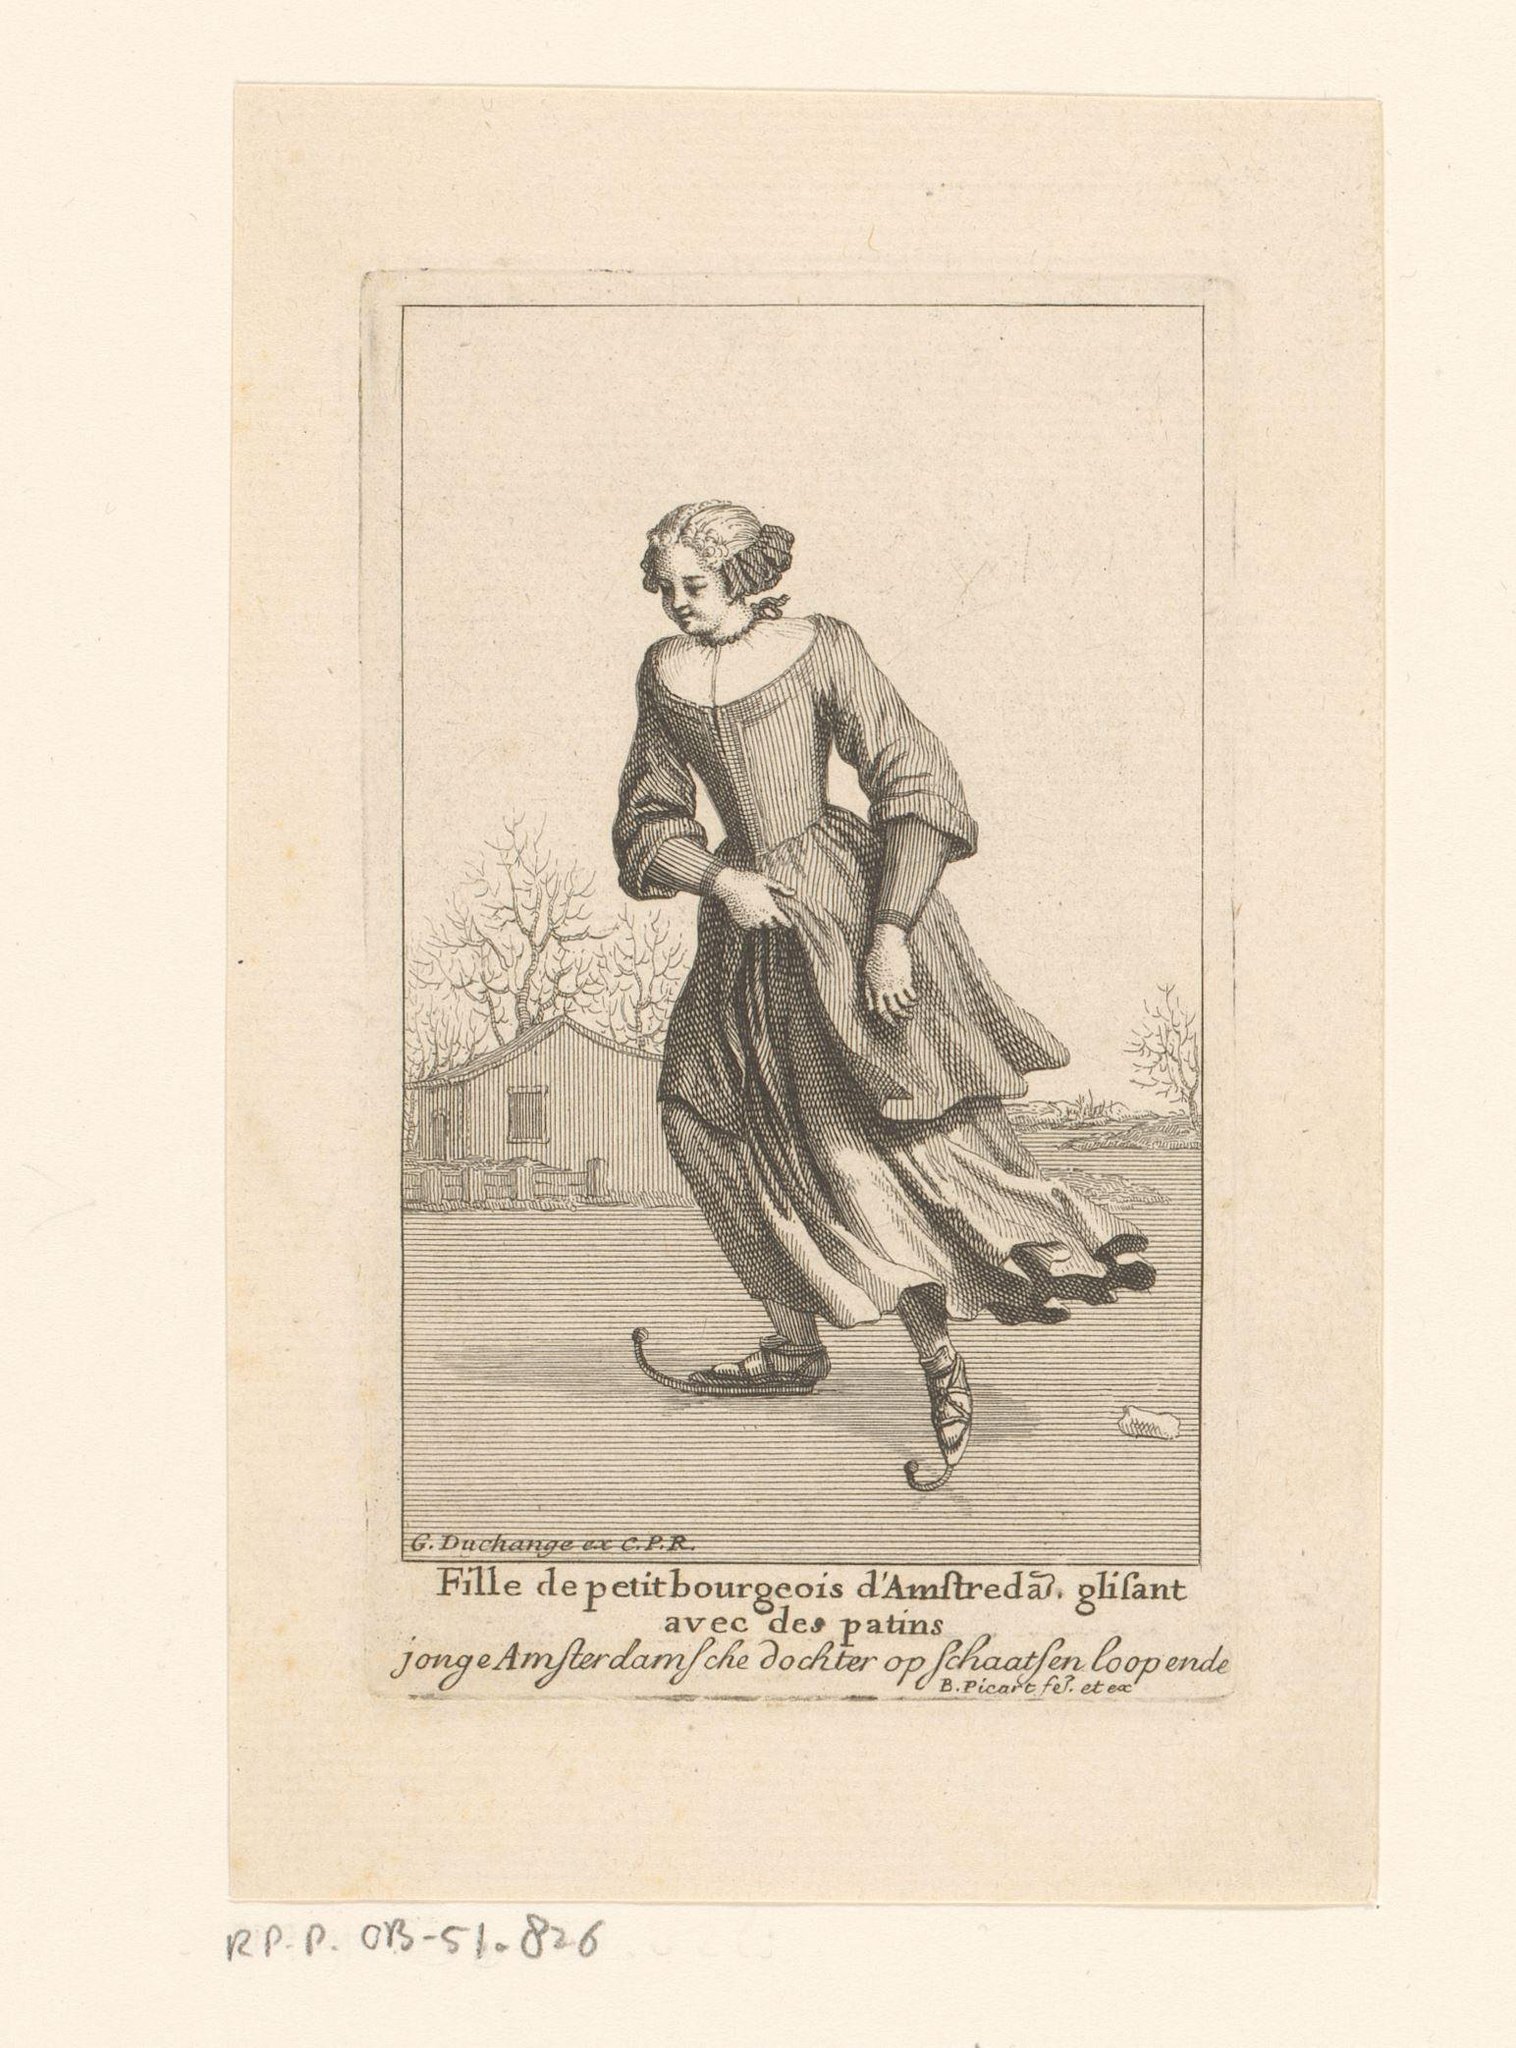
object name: print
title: Figuren in klederdracht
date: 1728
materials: paper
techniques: etching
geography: amsterdam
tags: clothing for the upper part of the body (jacket) (+ women's clothes), coat (+ women's clothes), clothes, costume (+ women's clothes), skates (winter sports), amsterdam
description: Schaatsende jonge vrouw, behorend tot de petit bourgeoisie van Amsterdam, ca. 1720. Ze is gekleed in een eenvoudige japon waarover ze een driekwart jasje draagt.